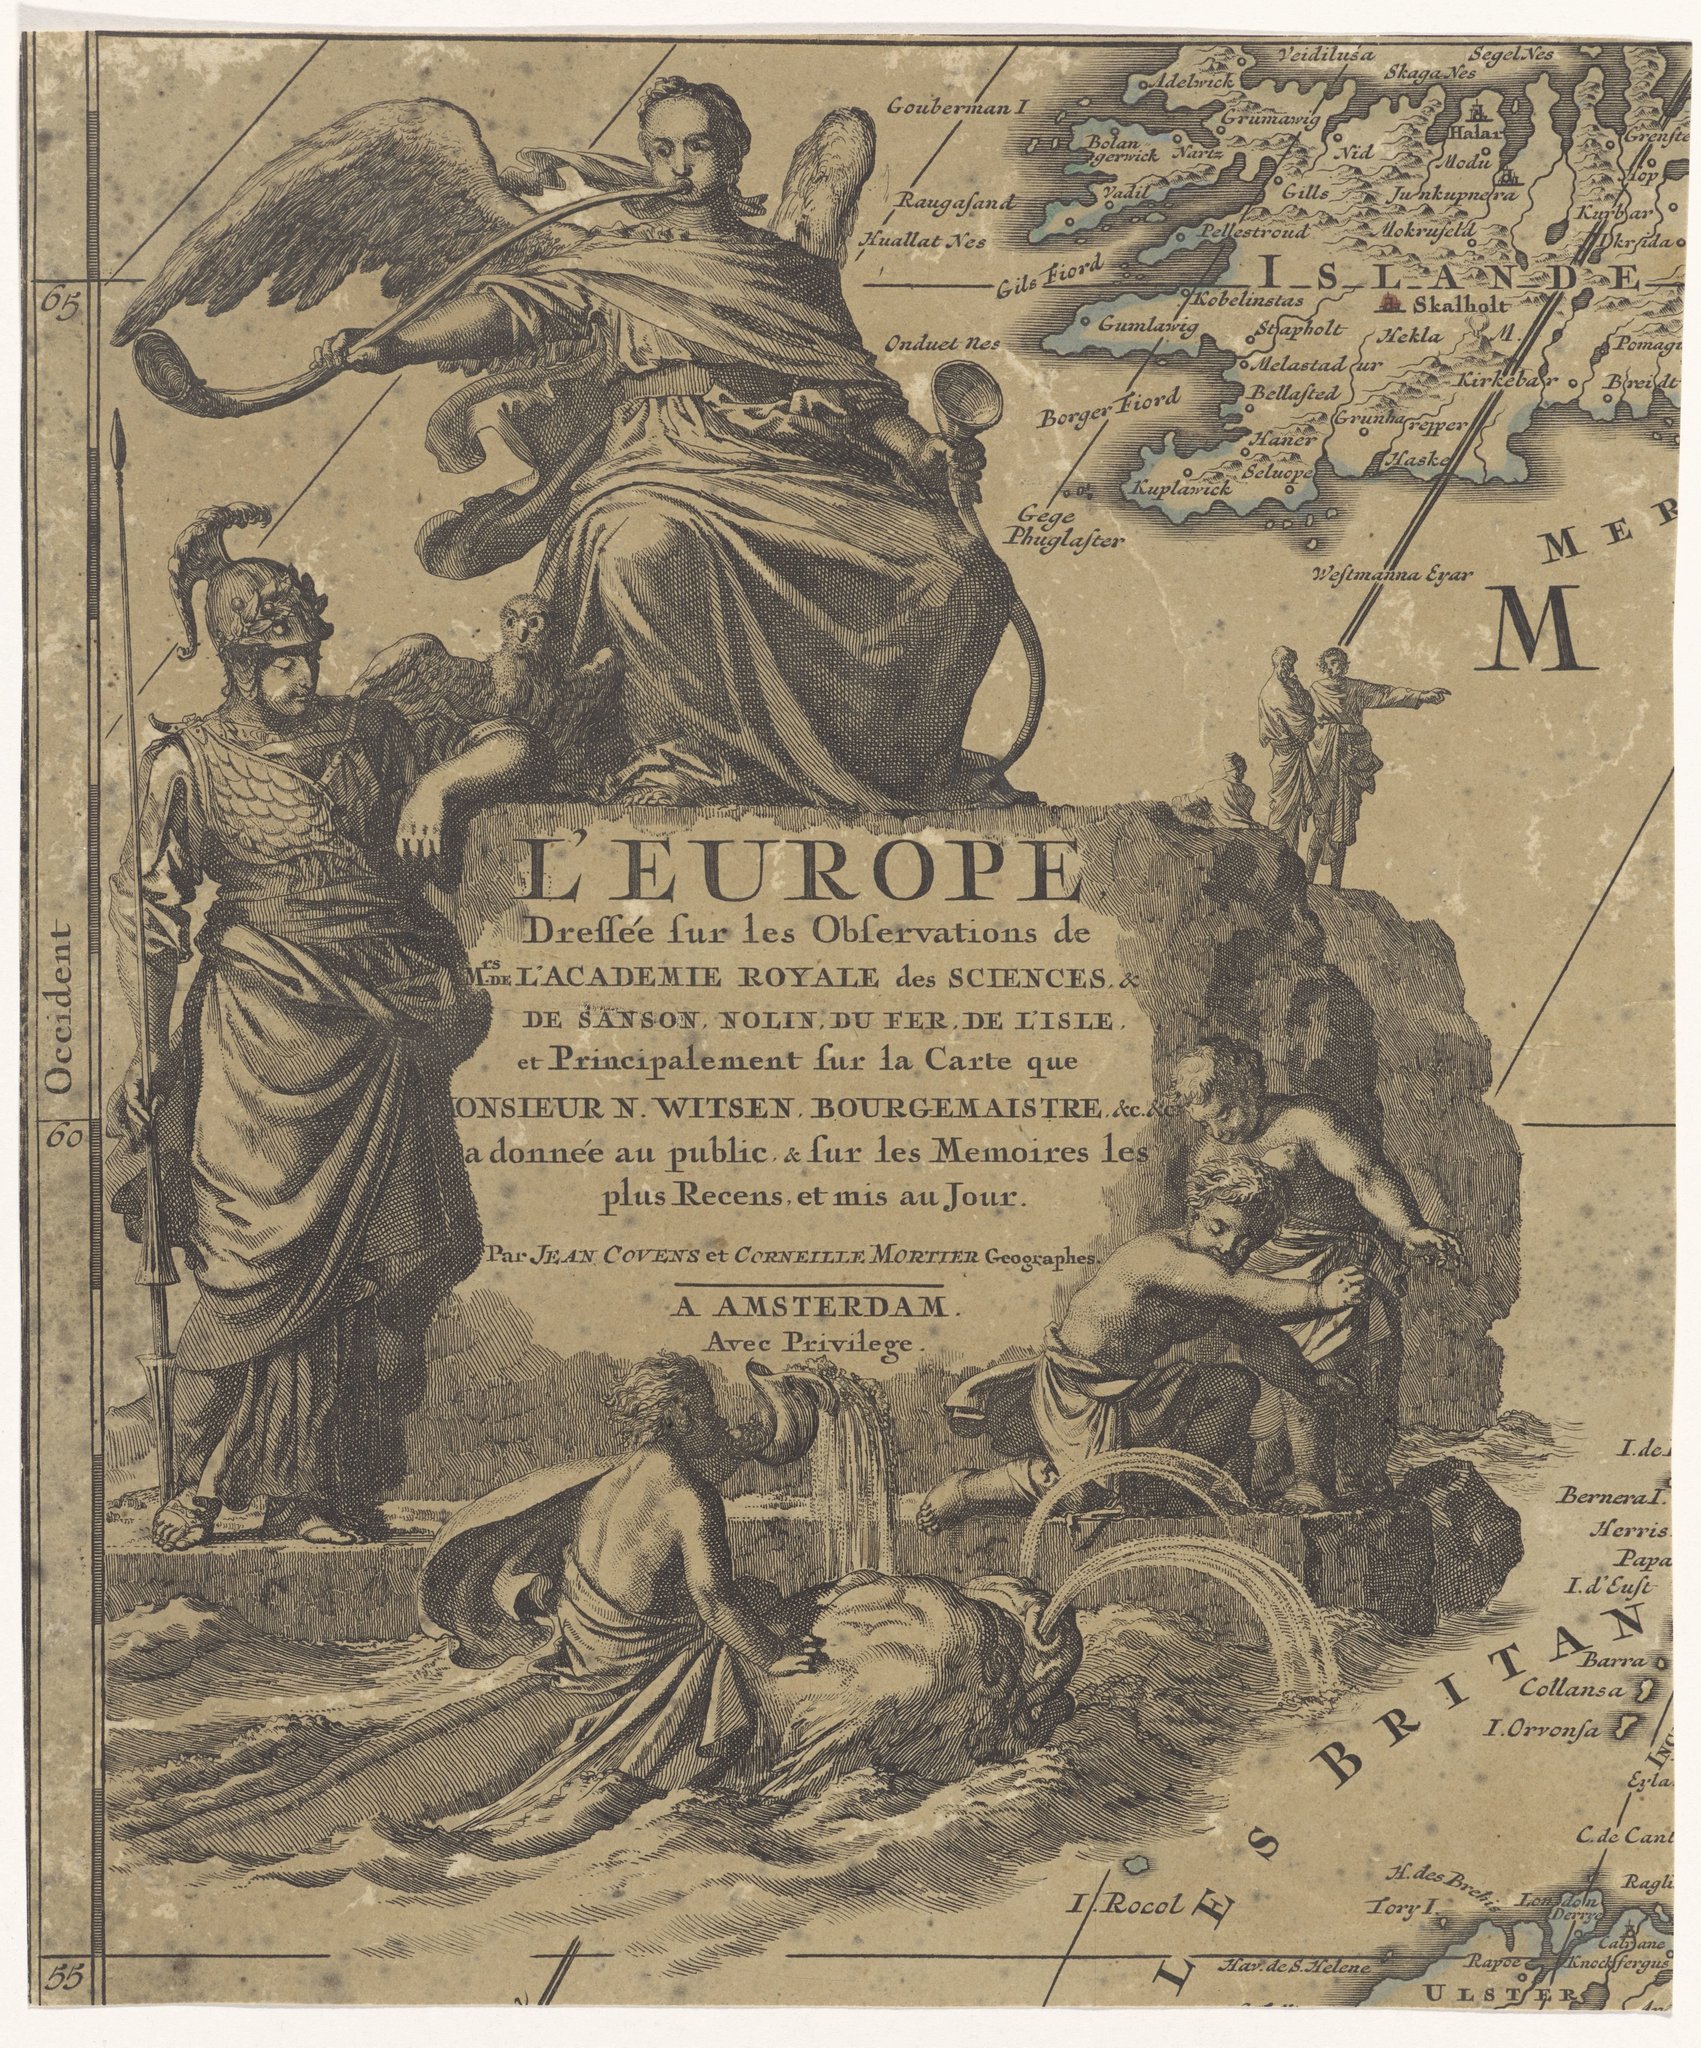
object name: print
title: L'Europe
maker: Anonymous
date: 1720-1772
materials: paper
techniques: etching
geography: amsterdam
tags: maps of separate countries or regions, (story of) minerva (pallas, athena), monsters of the sea, fame; 'fama', 'fama buona', 'fama chiara' (ripa)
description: Vignet voor een kaart van Europa, met Faam die vanaf een rots op haar bazuin blaast. Minerva staat iets lager en kijkt toe hoe twee kinderen nat gespetterd worden door een zeemonster.